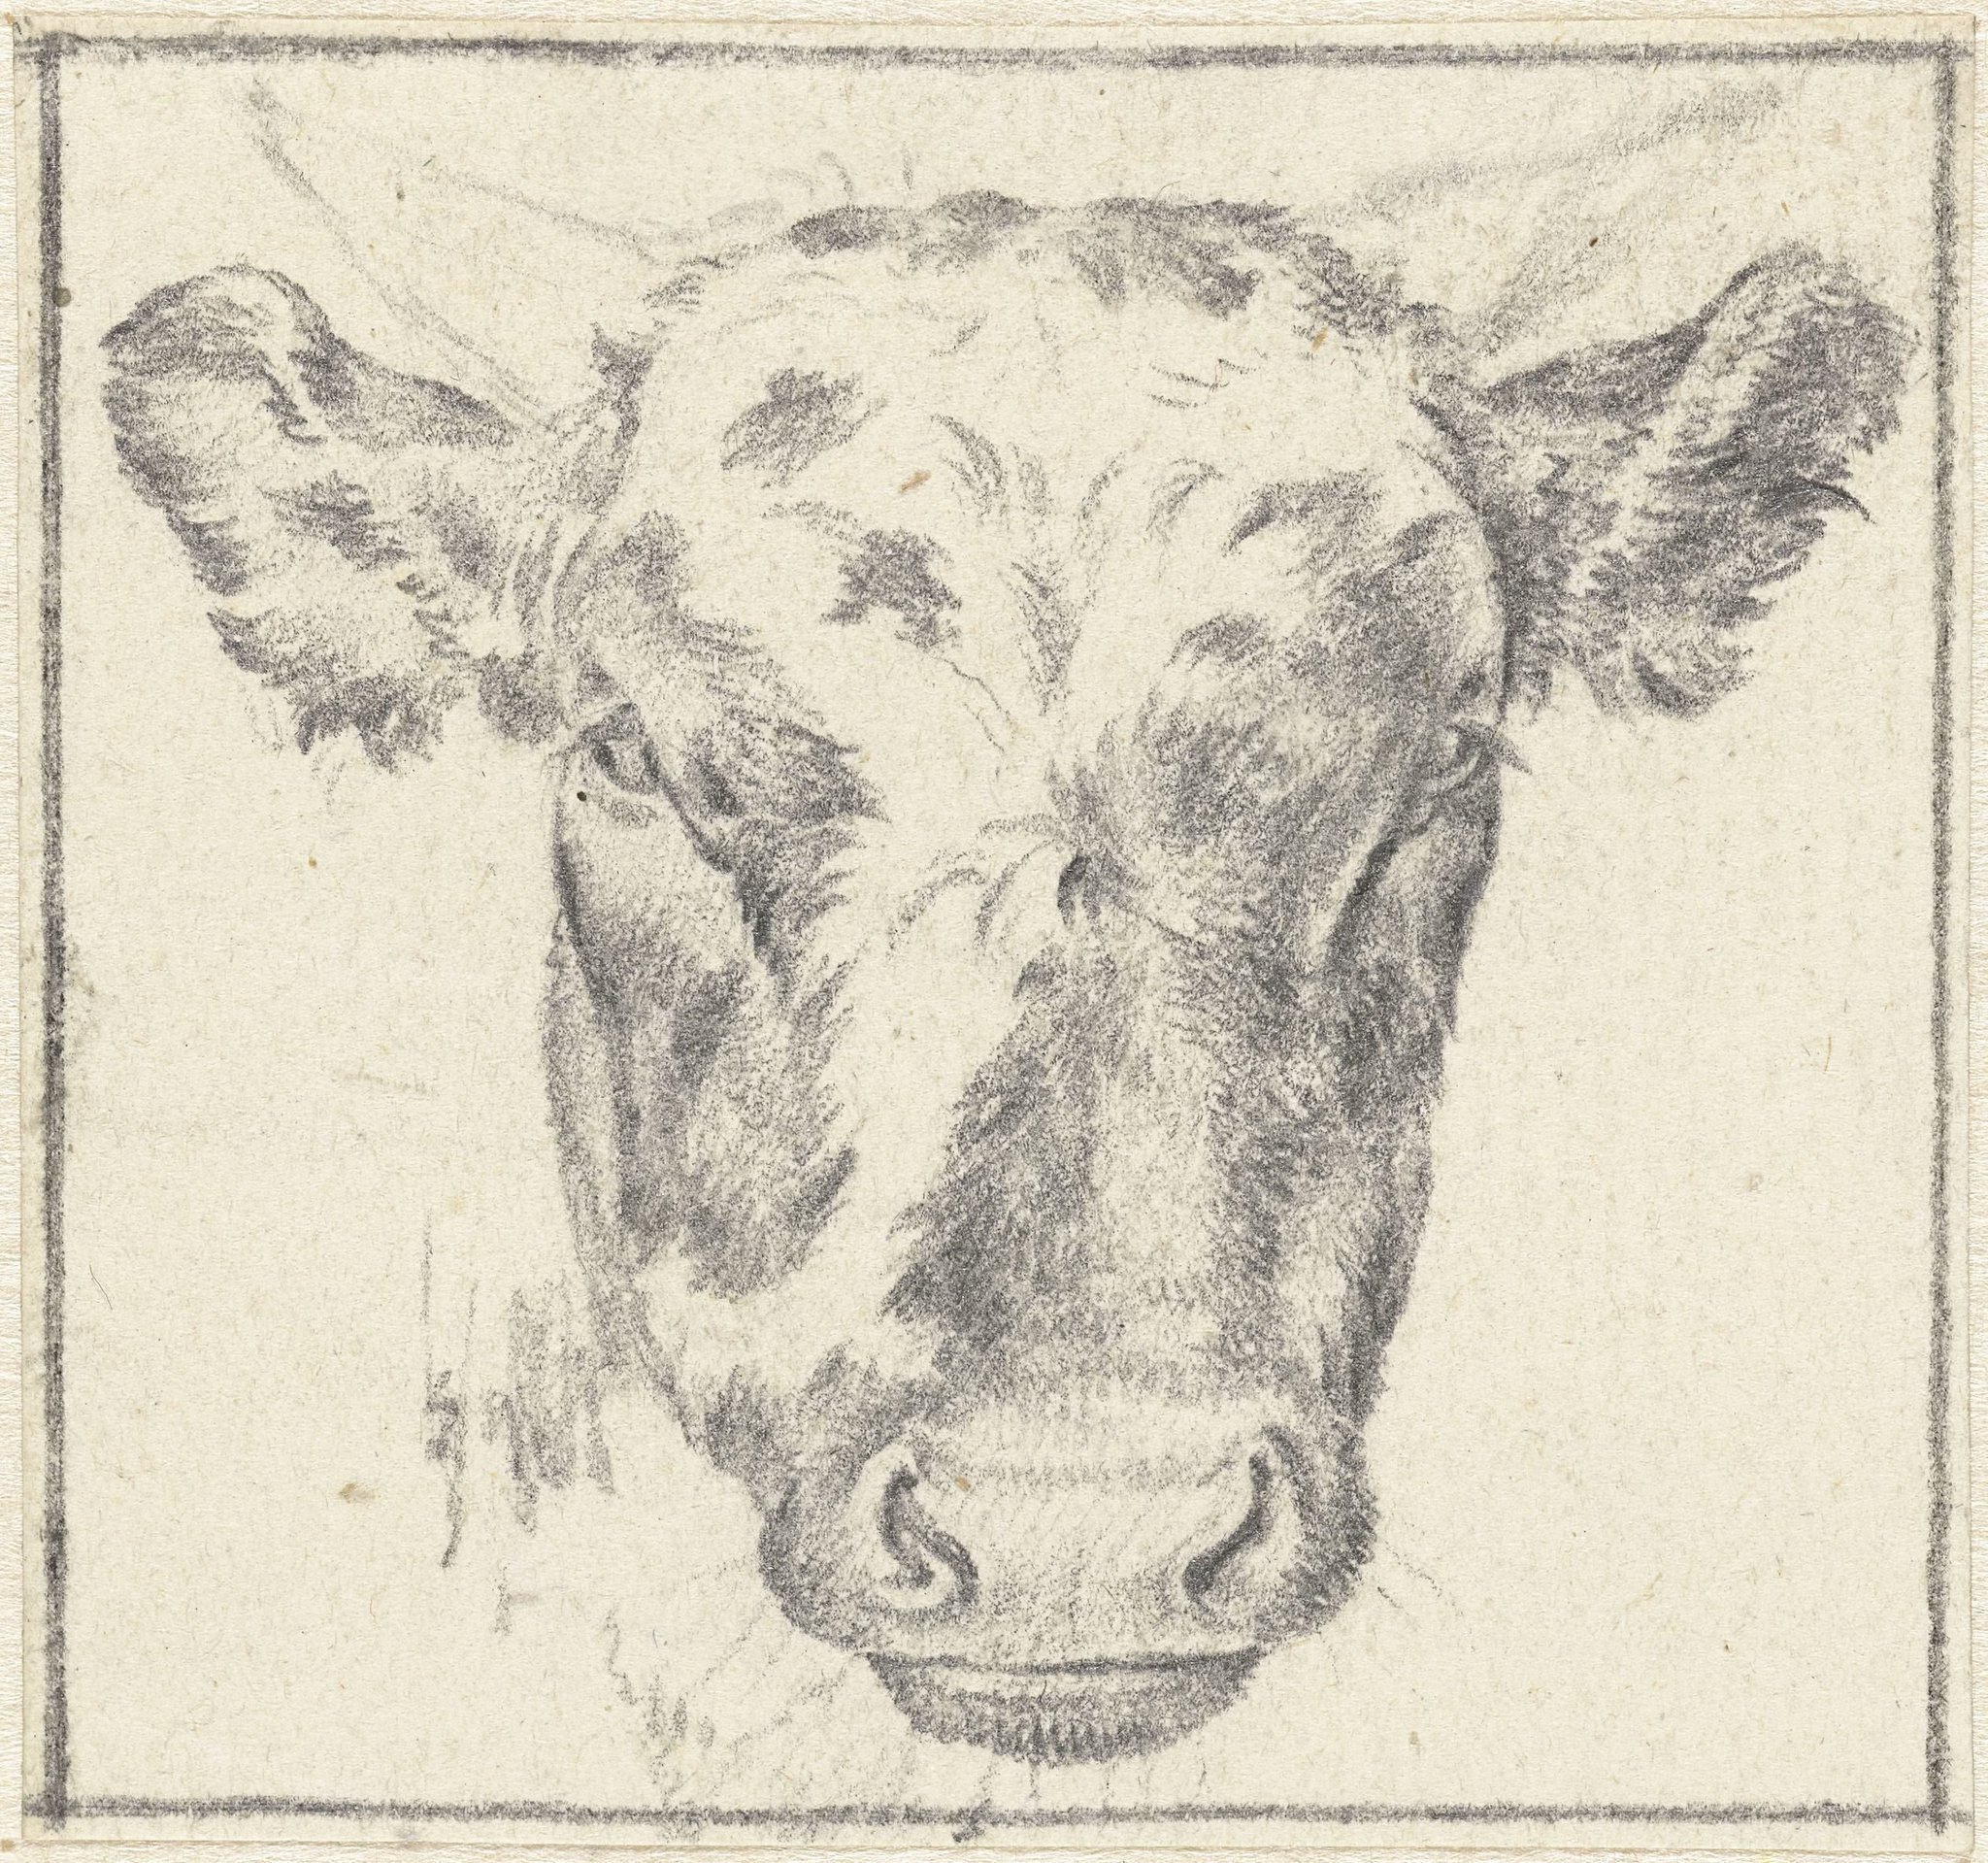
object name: drawing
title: Kalfskop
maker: pieter janson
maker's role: draughtsman, print maker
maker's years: 1765-1851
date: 1775-1851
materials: paper, pencil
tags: cow